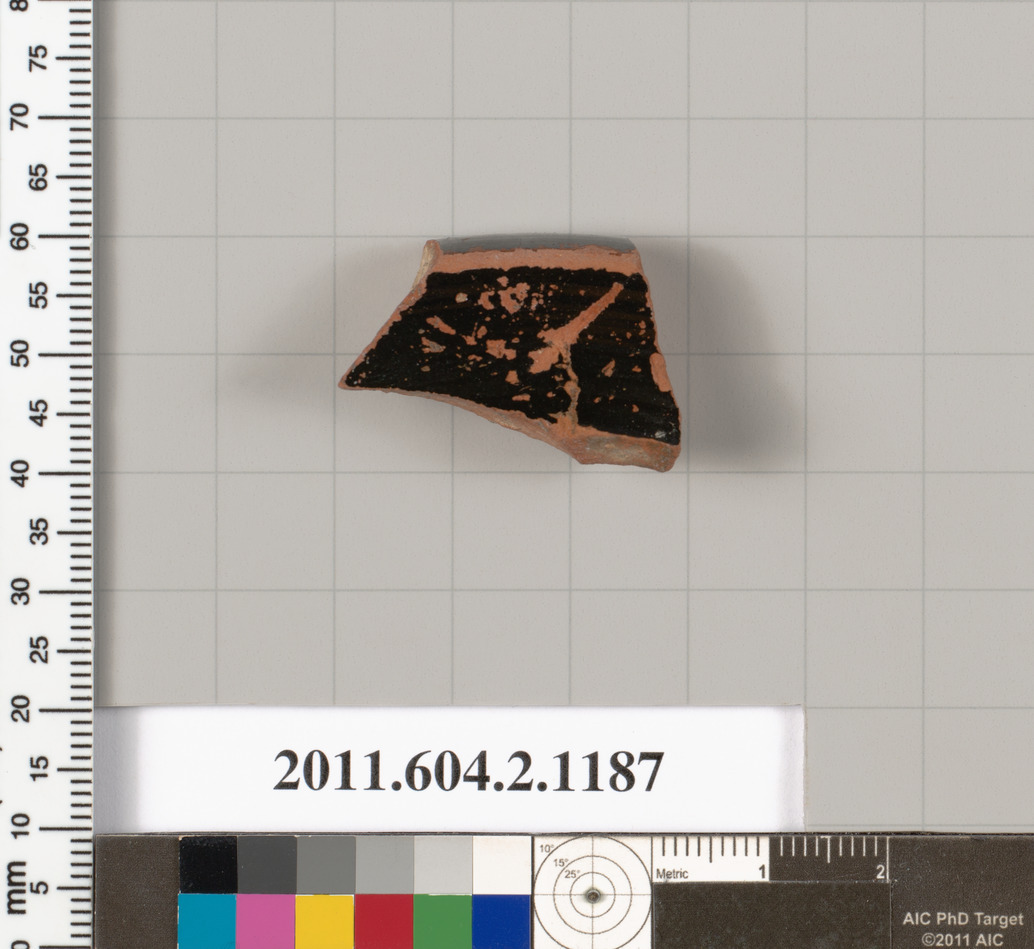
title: Terracotta fragment from an undetermined shape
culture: greek, attic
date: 500-401 BCE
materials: terracotta